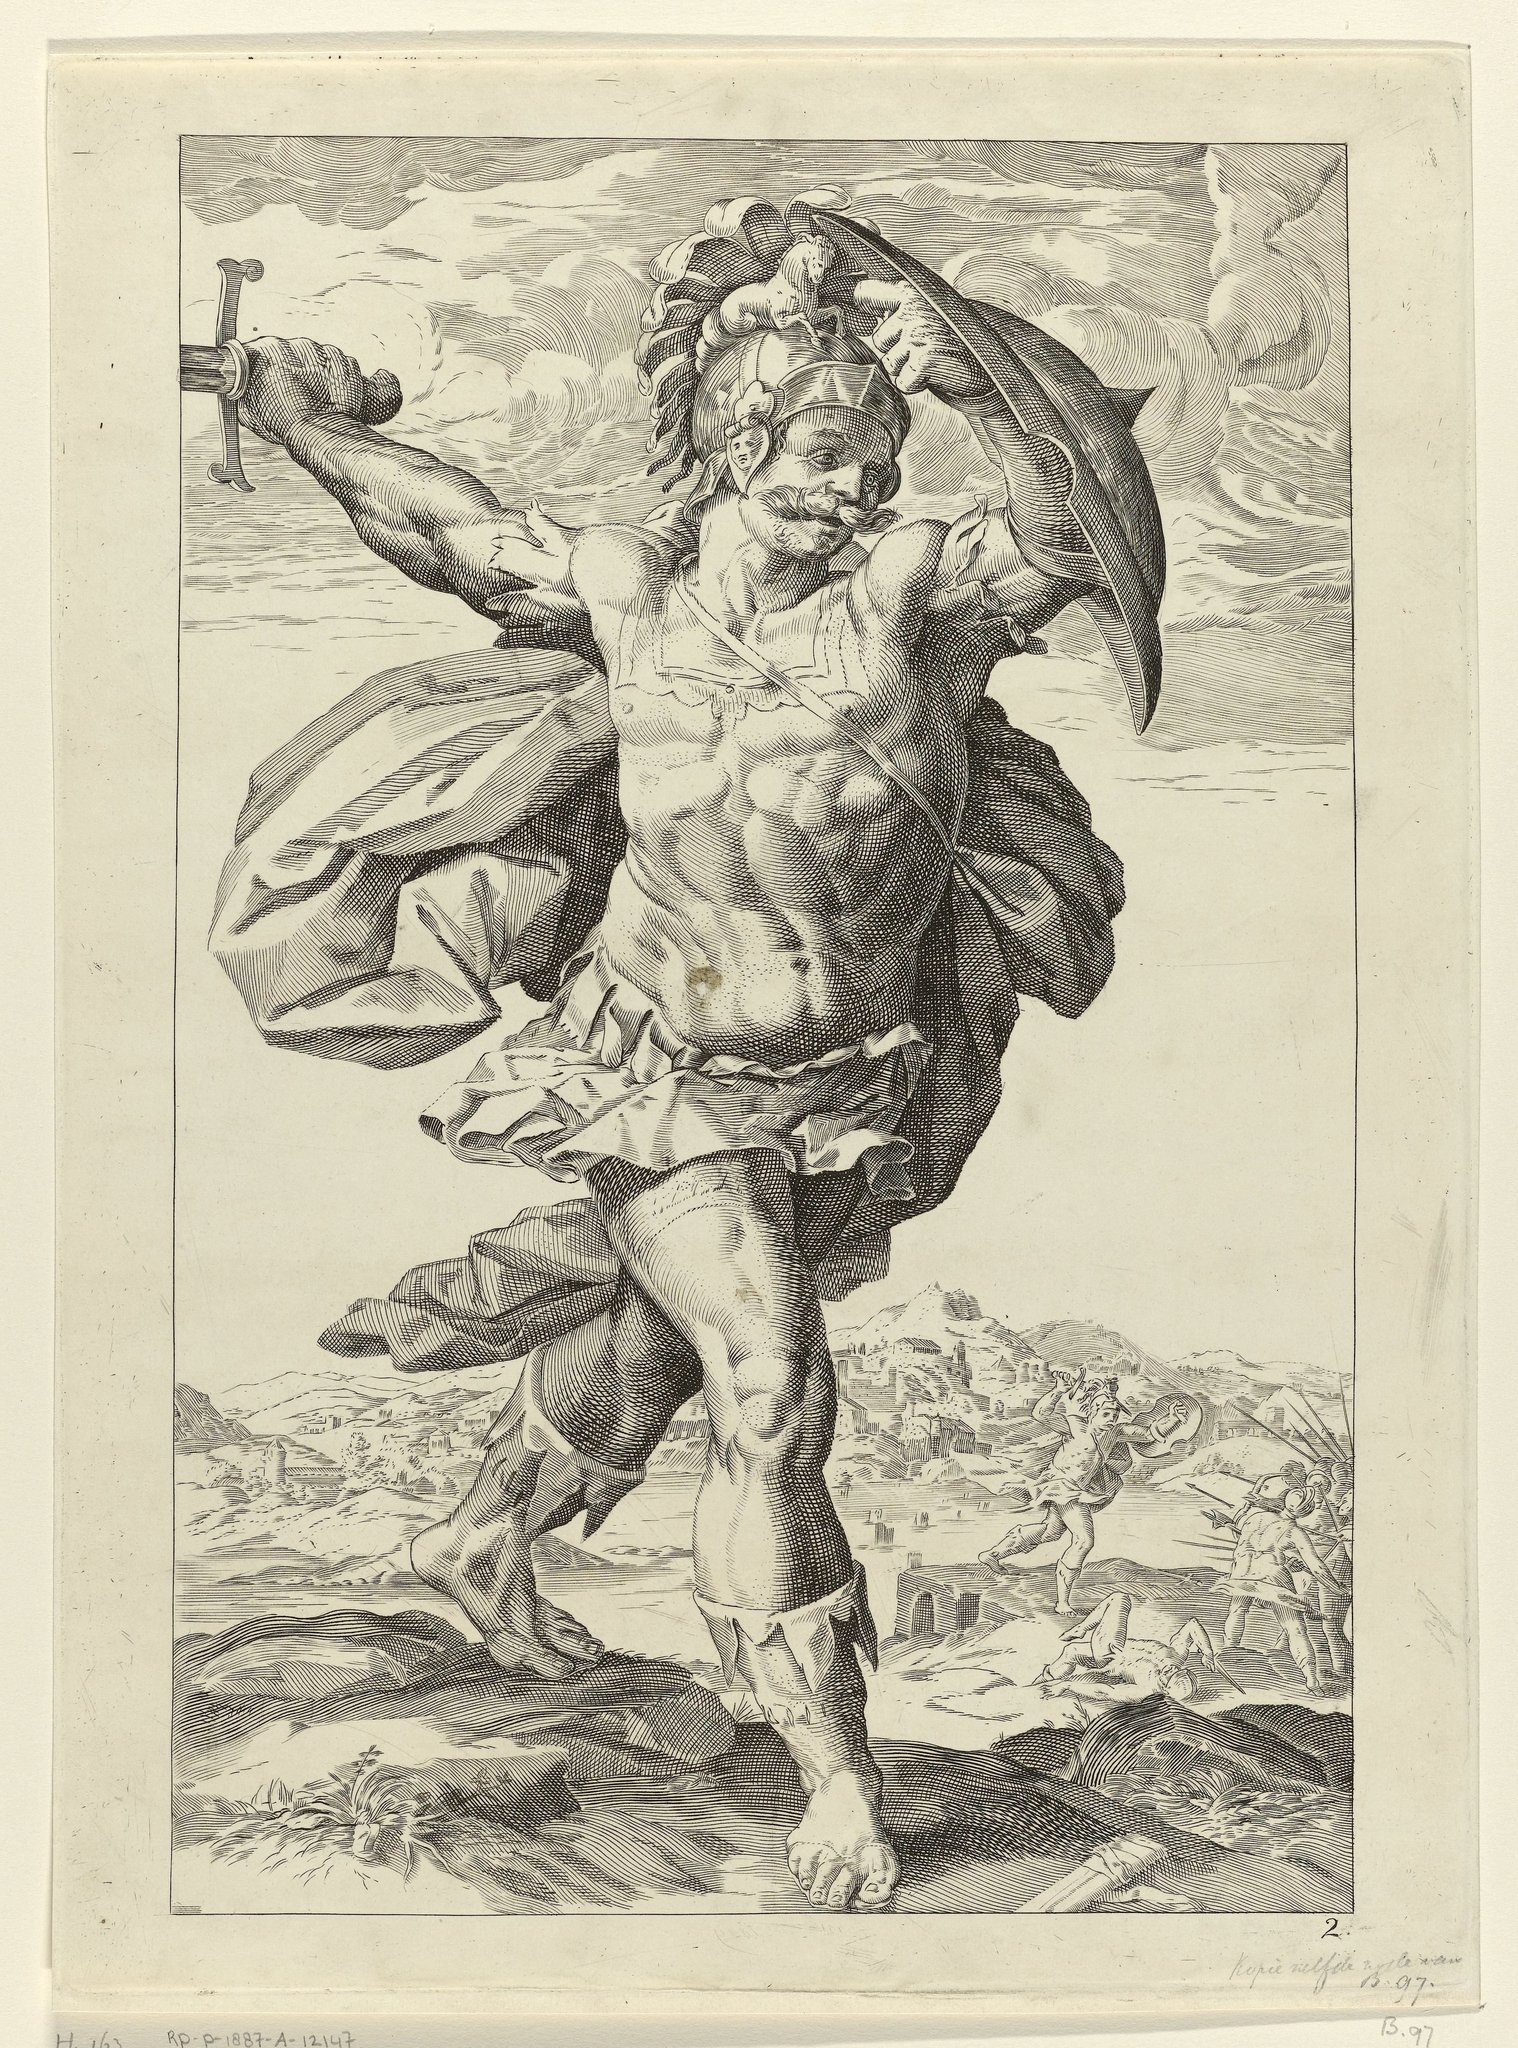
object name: print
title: Romeinse helden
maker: keijzer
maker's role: print maker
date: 1808-1829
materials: paper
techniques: engraving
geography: amsterdam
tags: horatius cocles at the pons sublicius: single-handed he keeps the etruscans at bay while the bridge is broken down by the romans behind him; he escapes by jumping into the tiber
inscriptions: collector's mark: Lugt 2228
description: In de New Hollstein wordt deze prent aangeduid als anonieme kopie e, maar de objectnummers RP-P-1887-A-12146 en RP-P-1887-A-12147 zijn hier per ongeluk verwisseld (kopie d en e). Dit is de eerste staat van de versie van Keijzer.